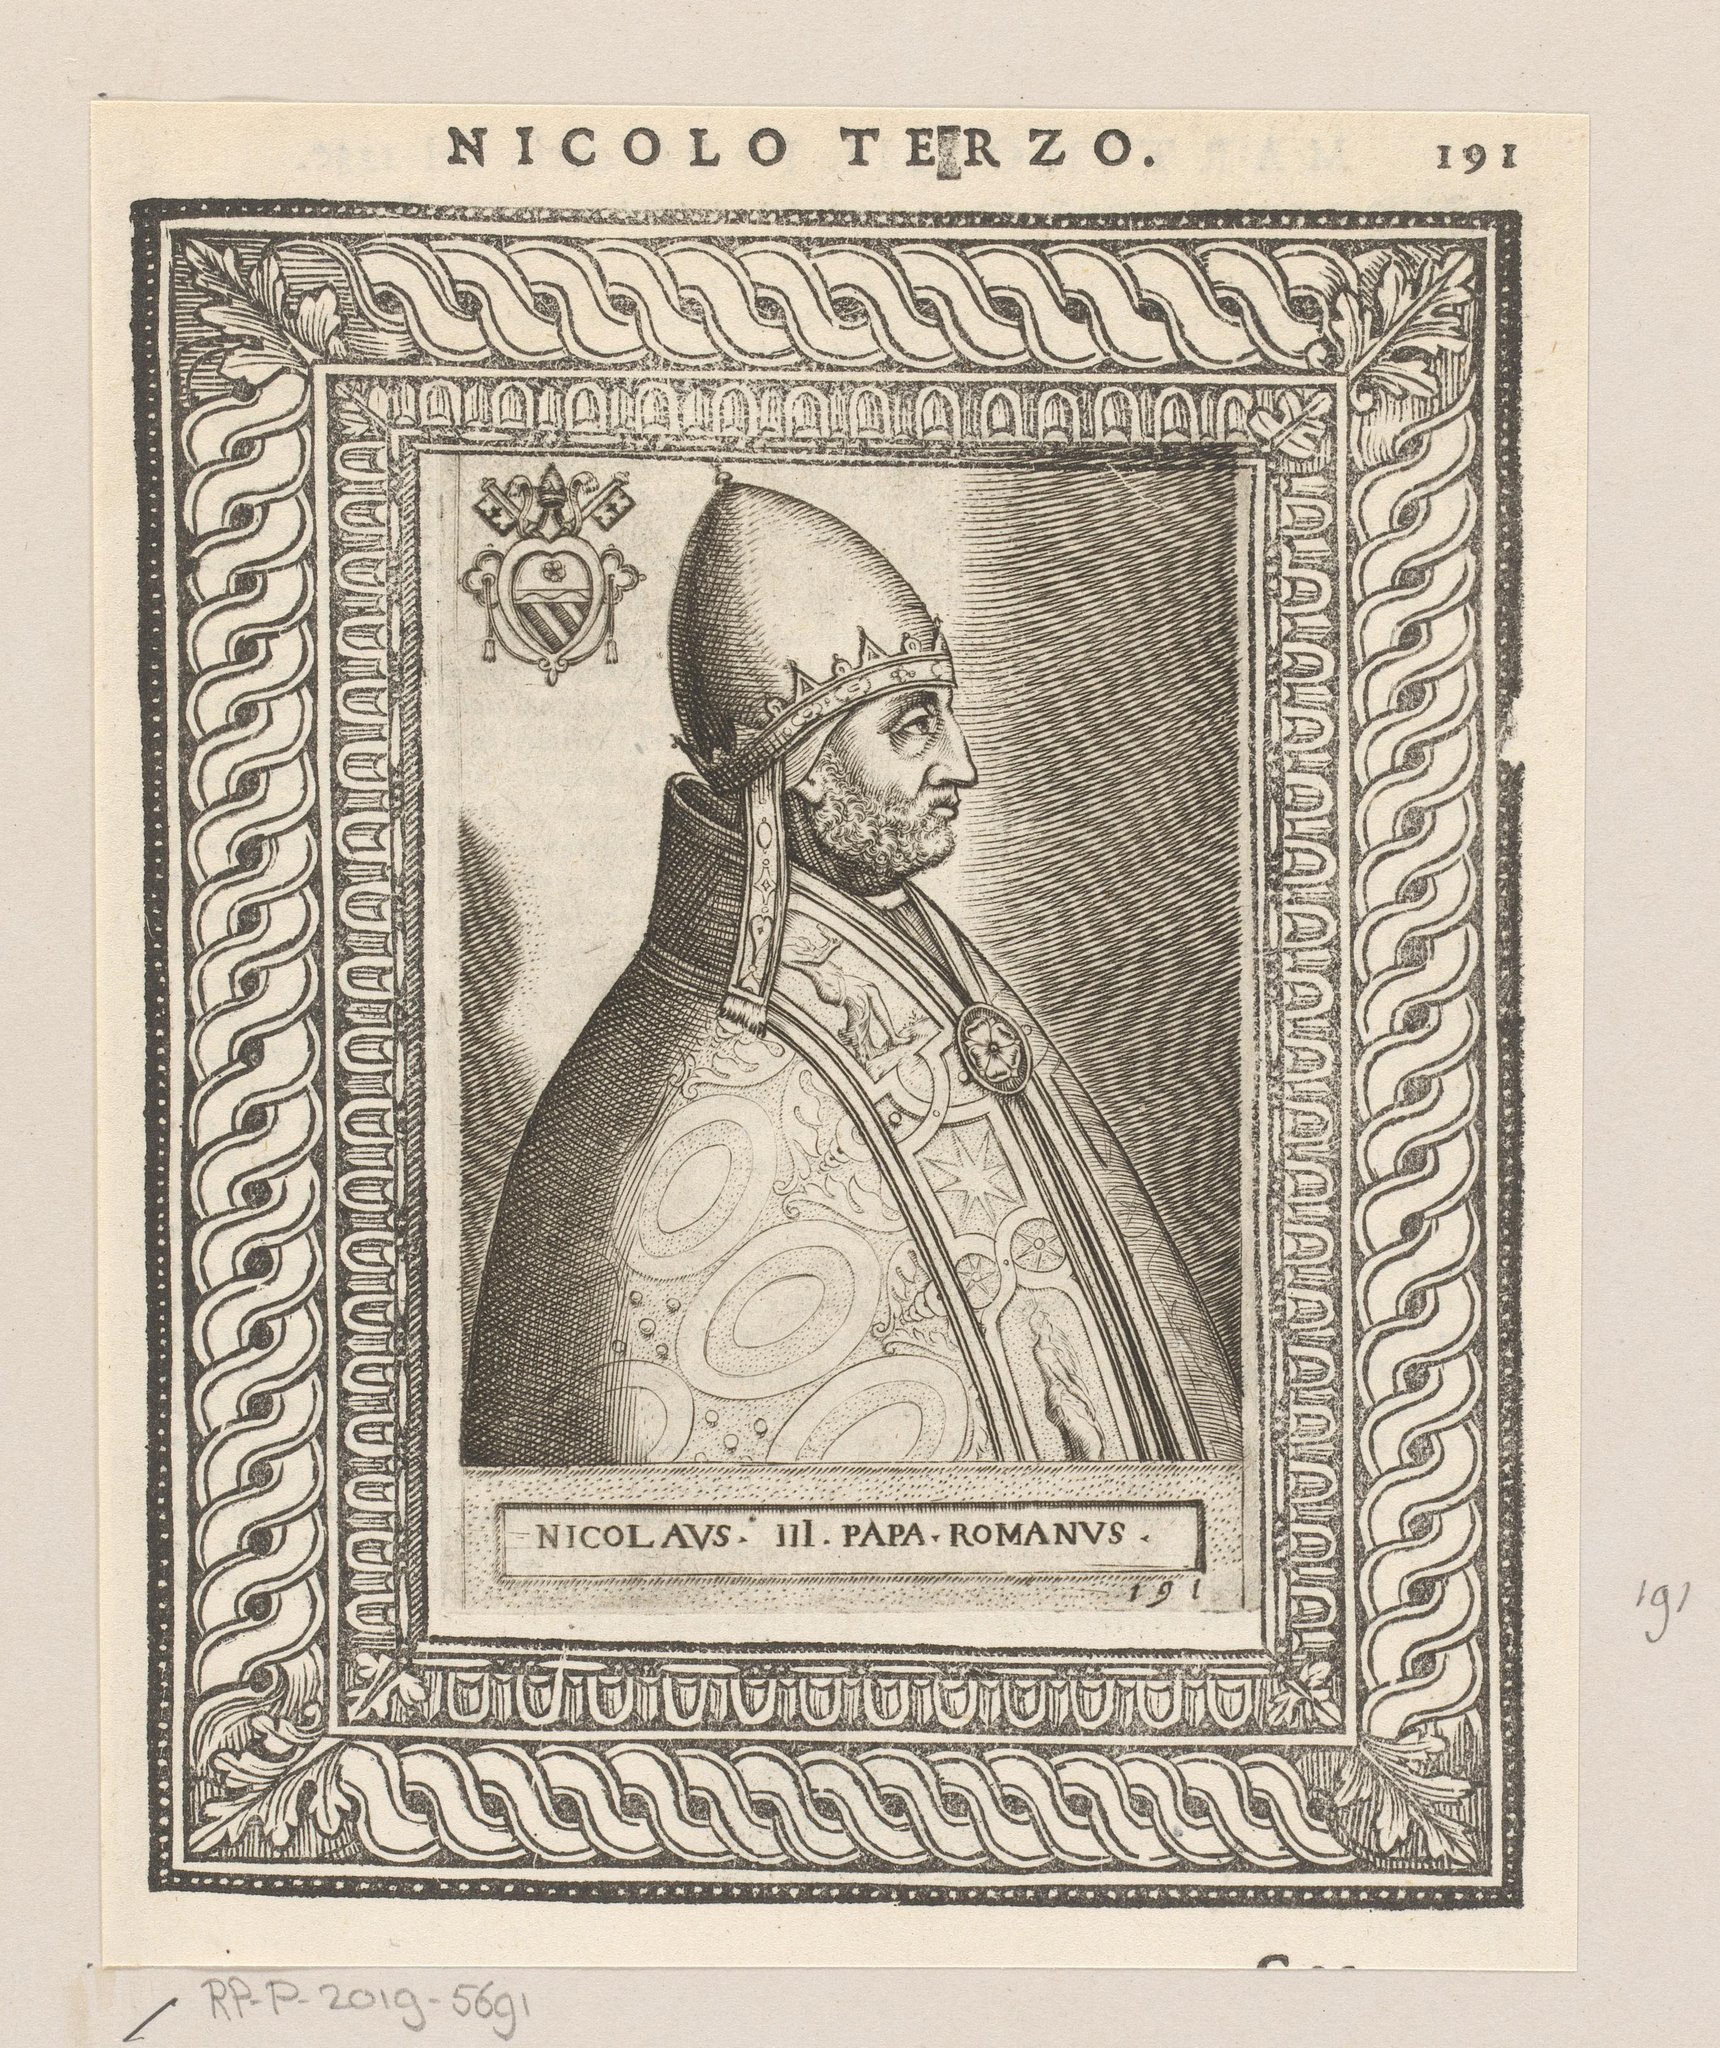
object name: book illustration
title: Portret van paus Nicolaas III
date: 1587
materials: paper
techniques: engraving, letterpress printing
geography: rome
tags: rome, historical persons, pope, armorial bearing, heraldry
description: Prent uit: Ciccarelli, Antonio. Le vite de Pontefici di Antonio Ciccarelli (...). Rome: Domenico Basa, 1587. Prent voor het eerst verschenen in: Cavalieri, Giovanni Battista de'. Pontificum romanorum effigies (...). Rome: Domenico Basa en Francesco Zanetti, 1580. Prent ook gebruikt in latere publicaties.